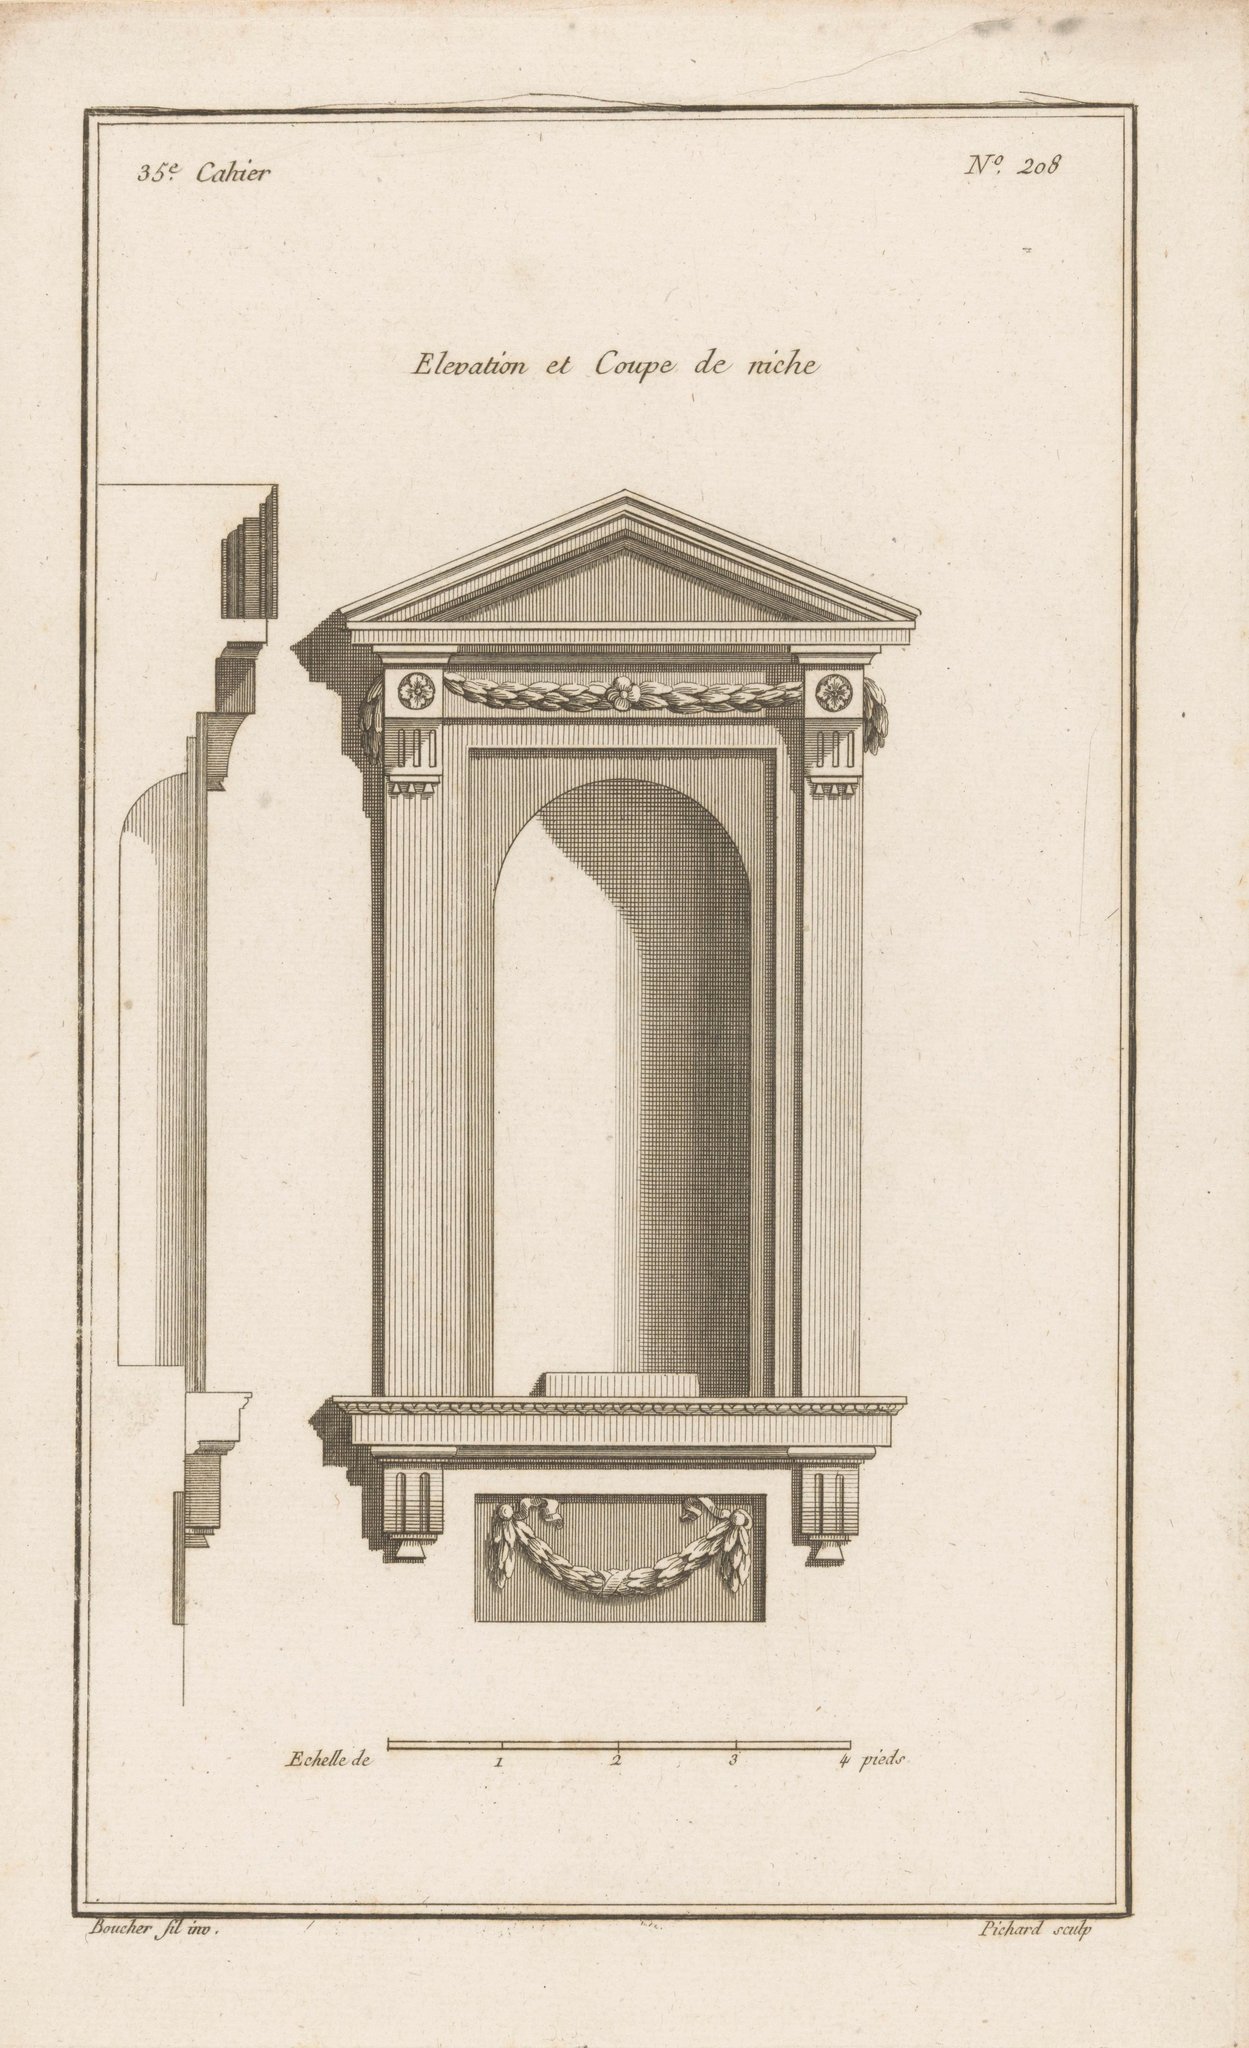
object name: ornament print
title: Nis met guirlandes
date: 1772-1779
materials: paper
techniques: engraving, etching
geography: paris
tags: 'concha' ~ architecture, ornament ~ festoon, garland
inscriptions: collector's mark: Lugt 2760, collector's mark: Lugt 2228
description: Voor- en zijaanzicht van een nis gedecoreerd met guirlandes. Prentnummer 208.